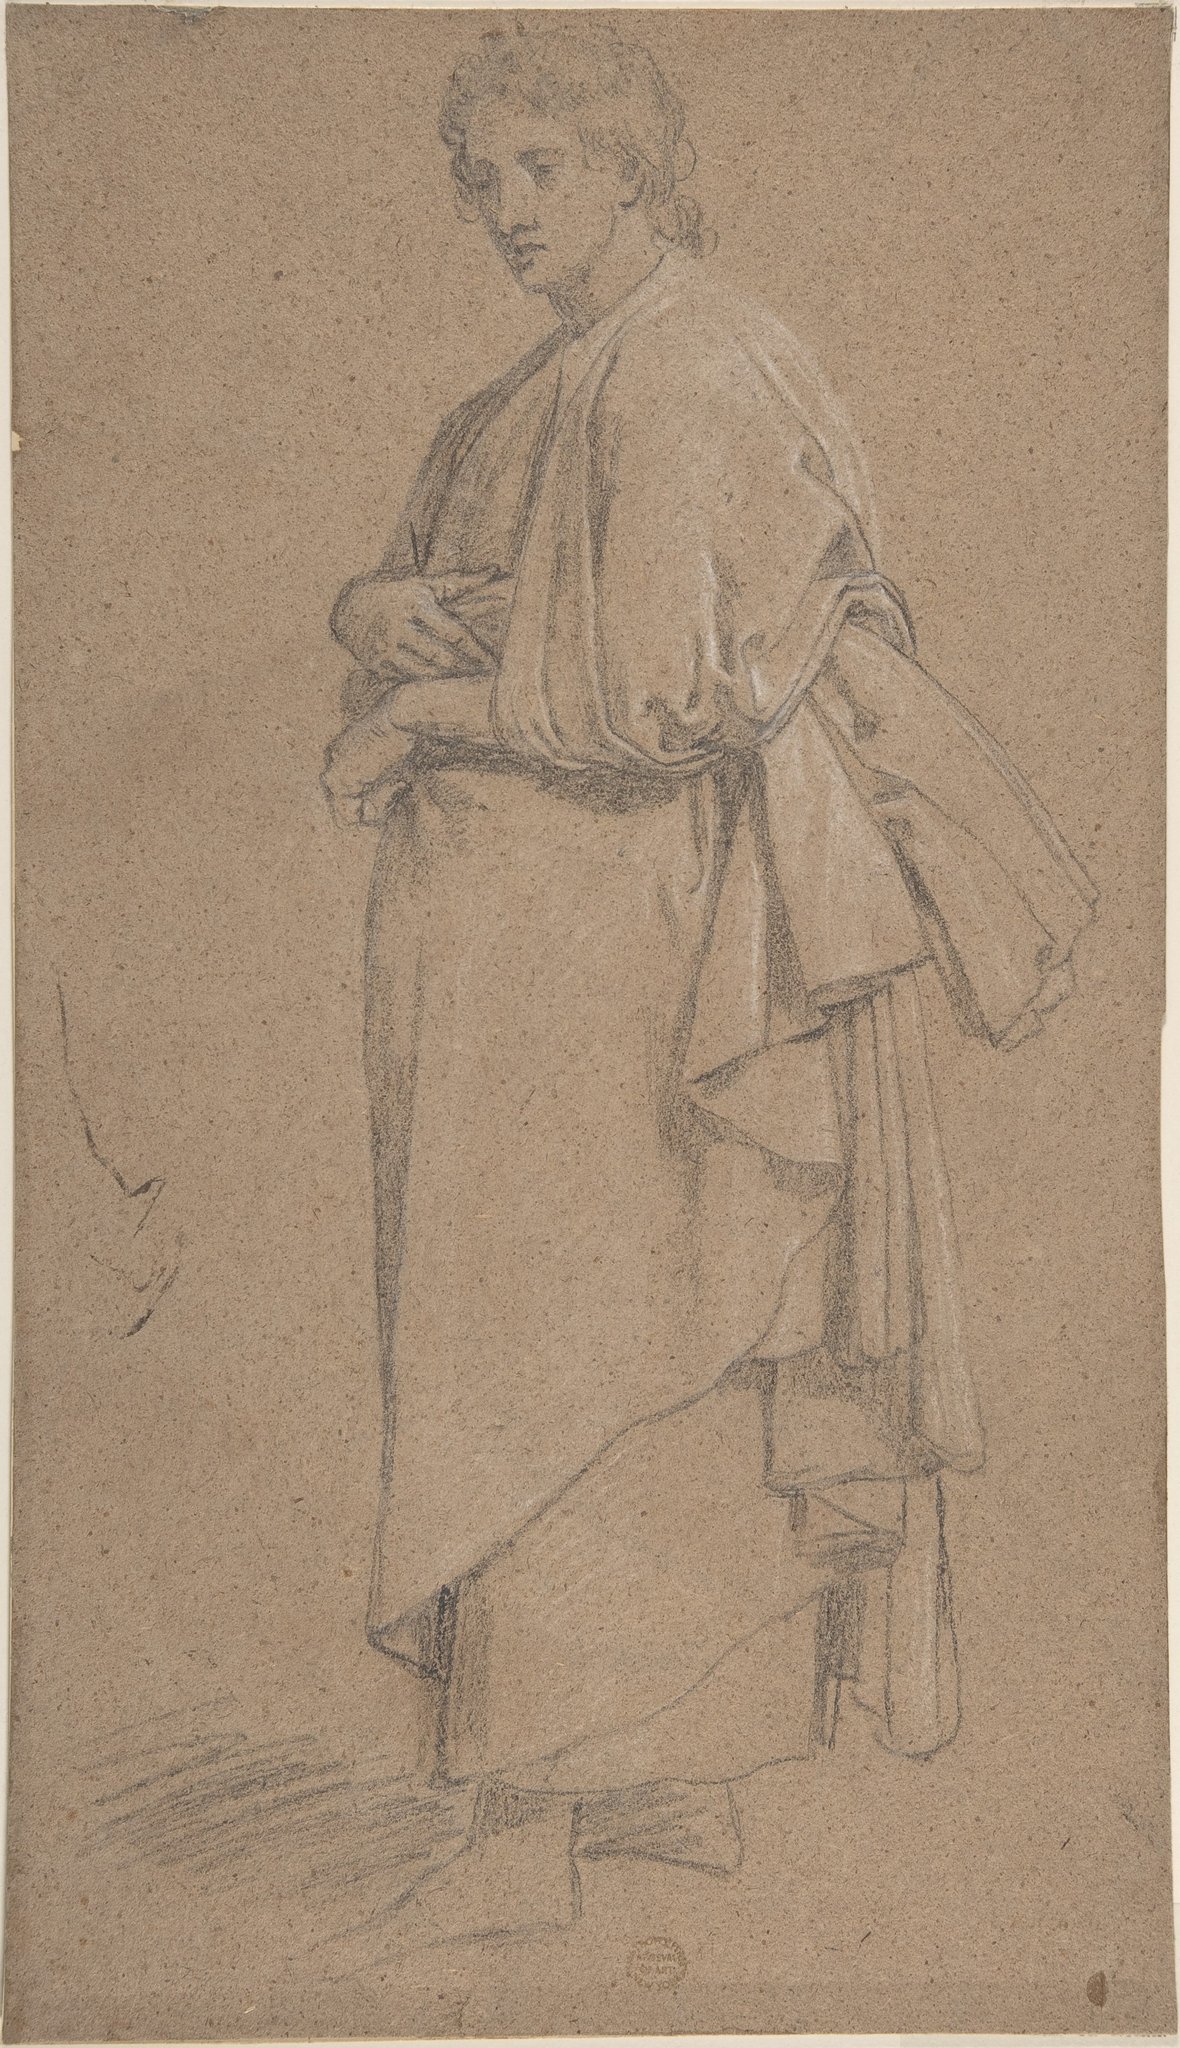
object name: drawing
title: Man in Roman Toga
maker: anonymous, french, 18th century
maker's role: artist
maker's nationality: french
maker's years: 1700-1800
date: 1701-1800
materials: chalk, paper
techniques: heightening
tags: men